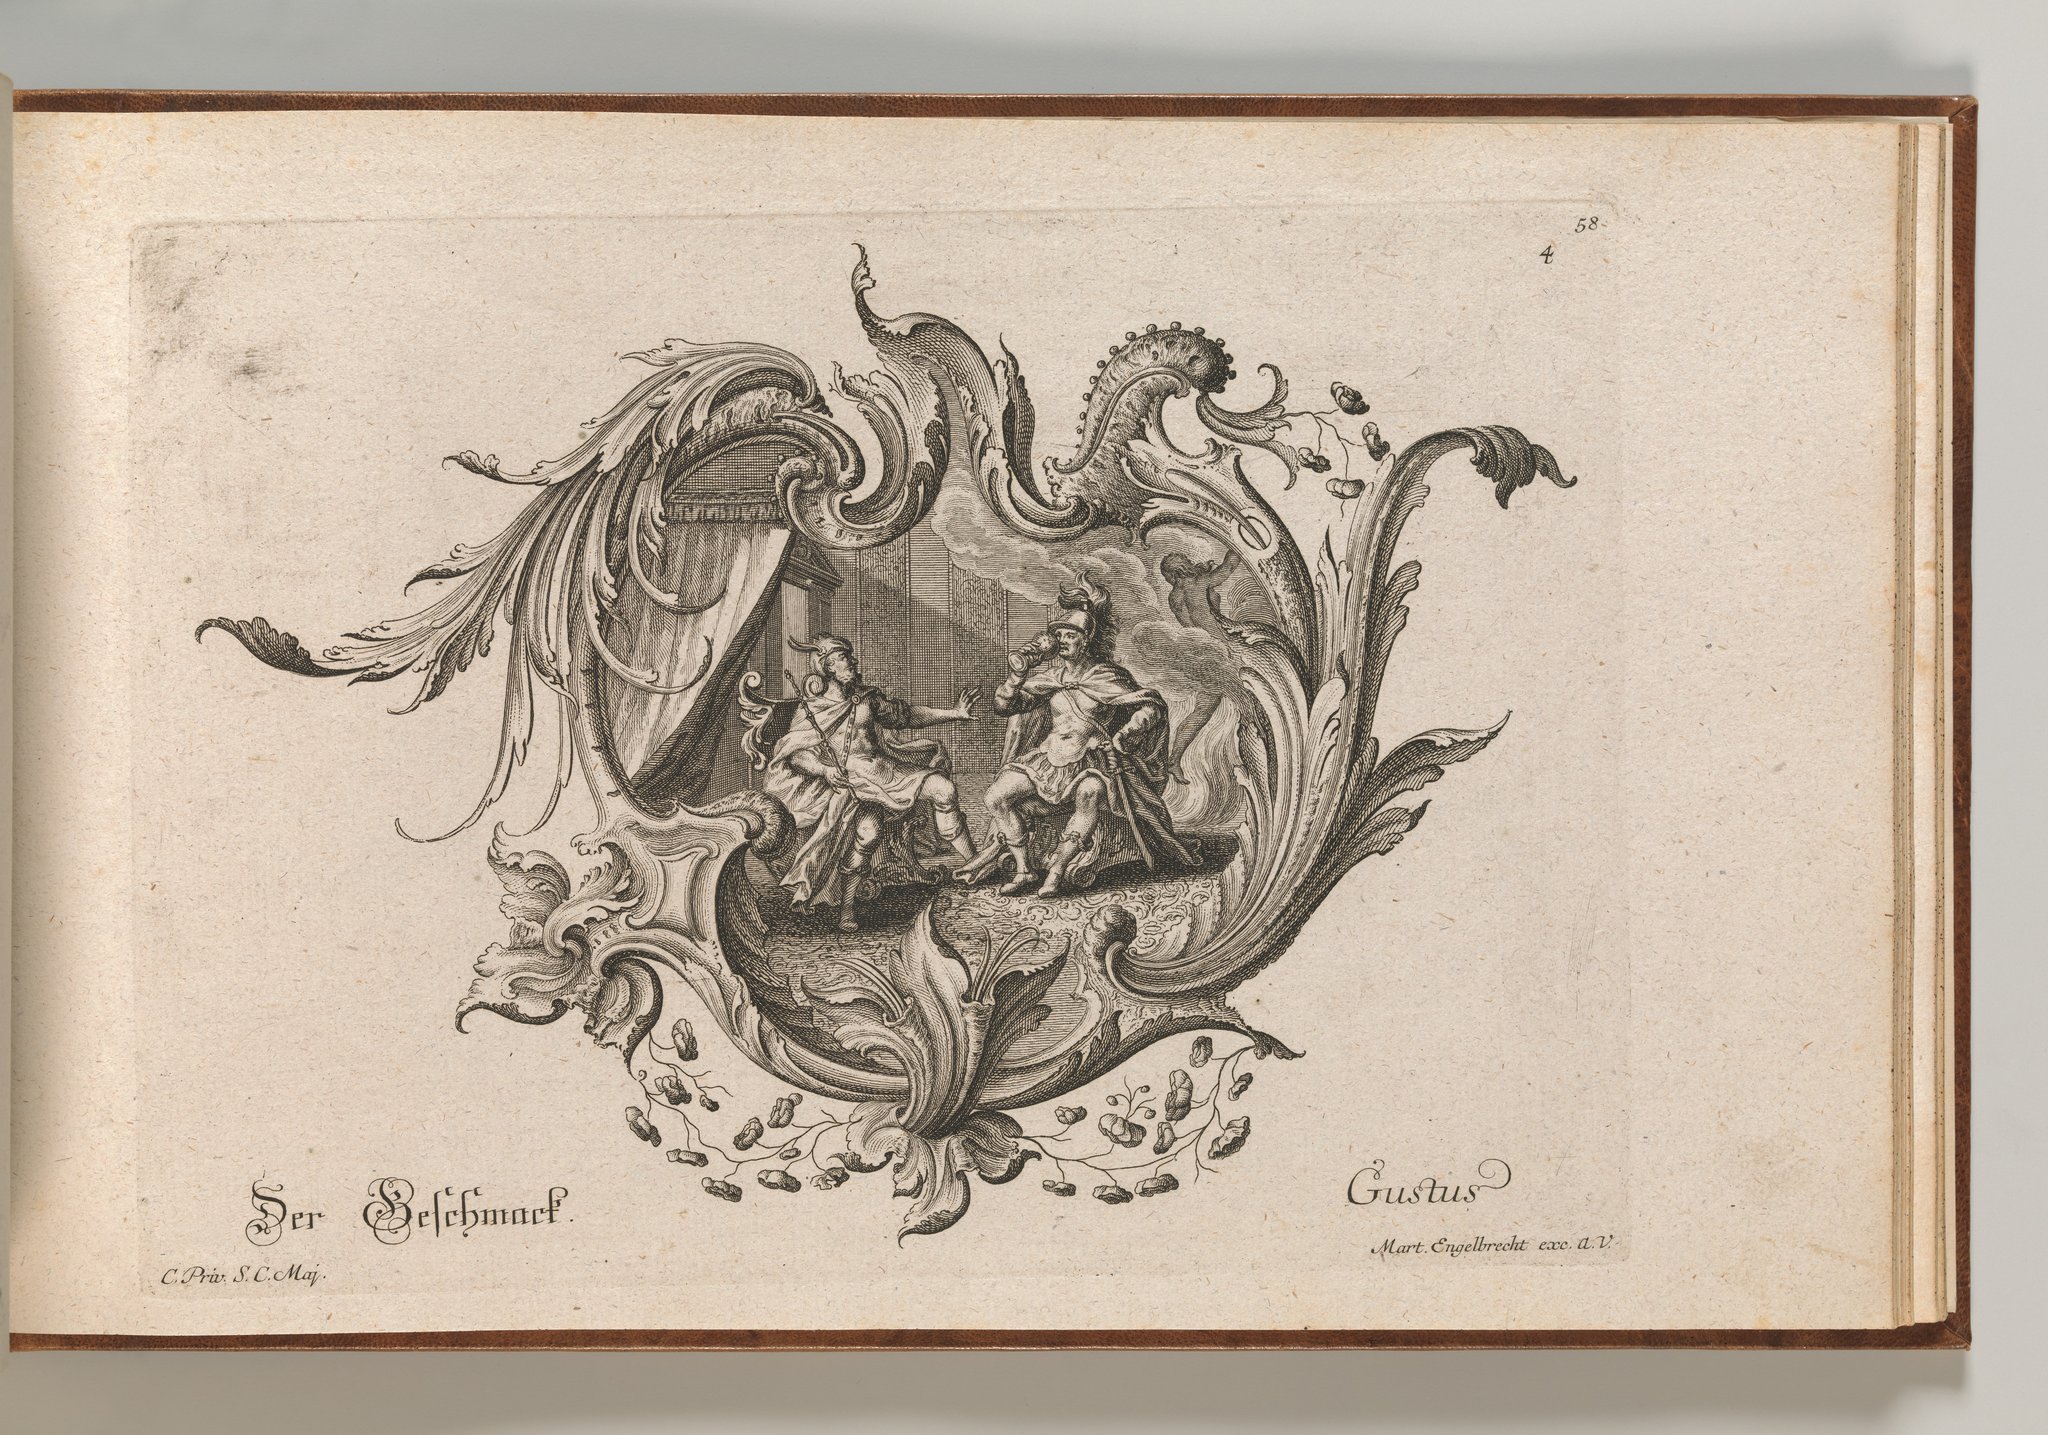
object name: album print ornament architecture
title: Design for a Cartouche and a Representation of 'Taste', Plate 4 from 'Neu Inventierte auf die artigste Facon Sehr nutzliche Schild.'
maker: johann georg pintz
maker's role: engraver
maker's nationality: central european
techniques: etching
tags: cartouches,men